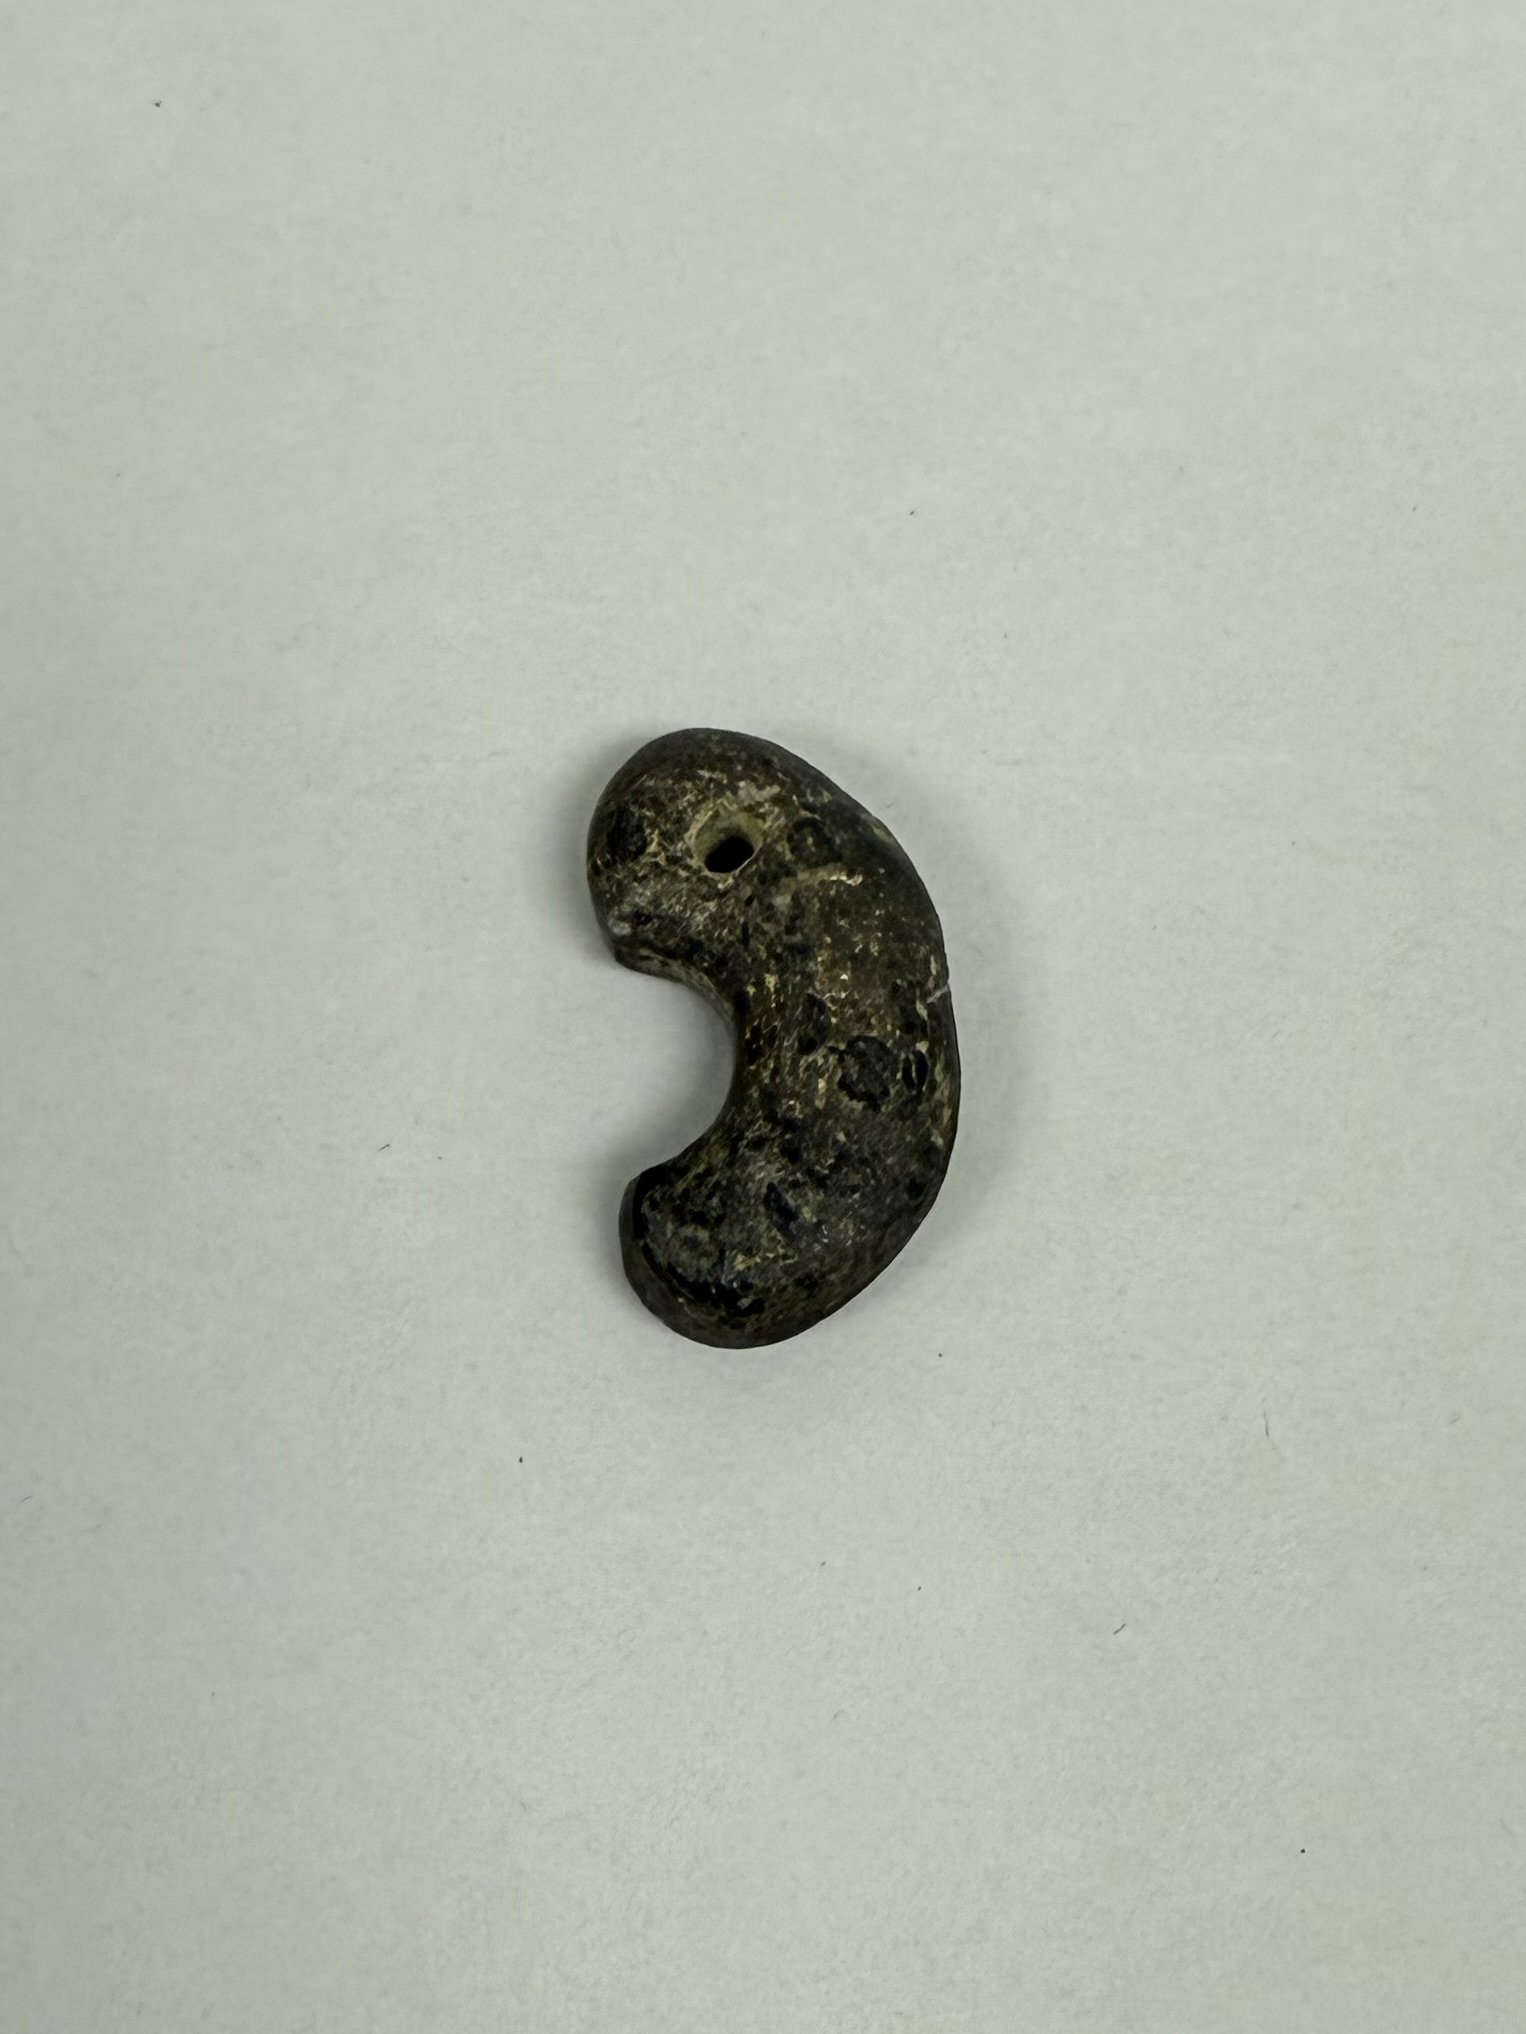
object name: jewel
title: Tiger Claw Jewel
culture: japanese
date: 501-600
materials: stone